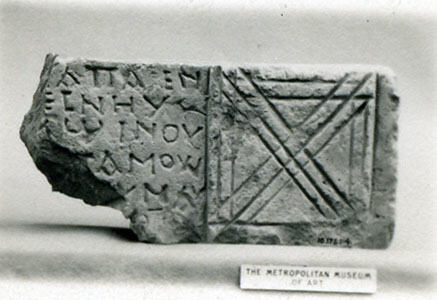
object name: fragment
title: Fragment of an Inscribed Block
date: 501-700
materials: limestone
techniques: incising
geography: egypt